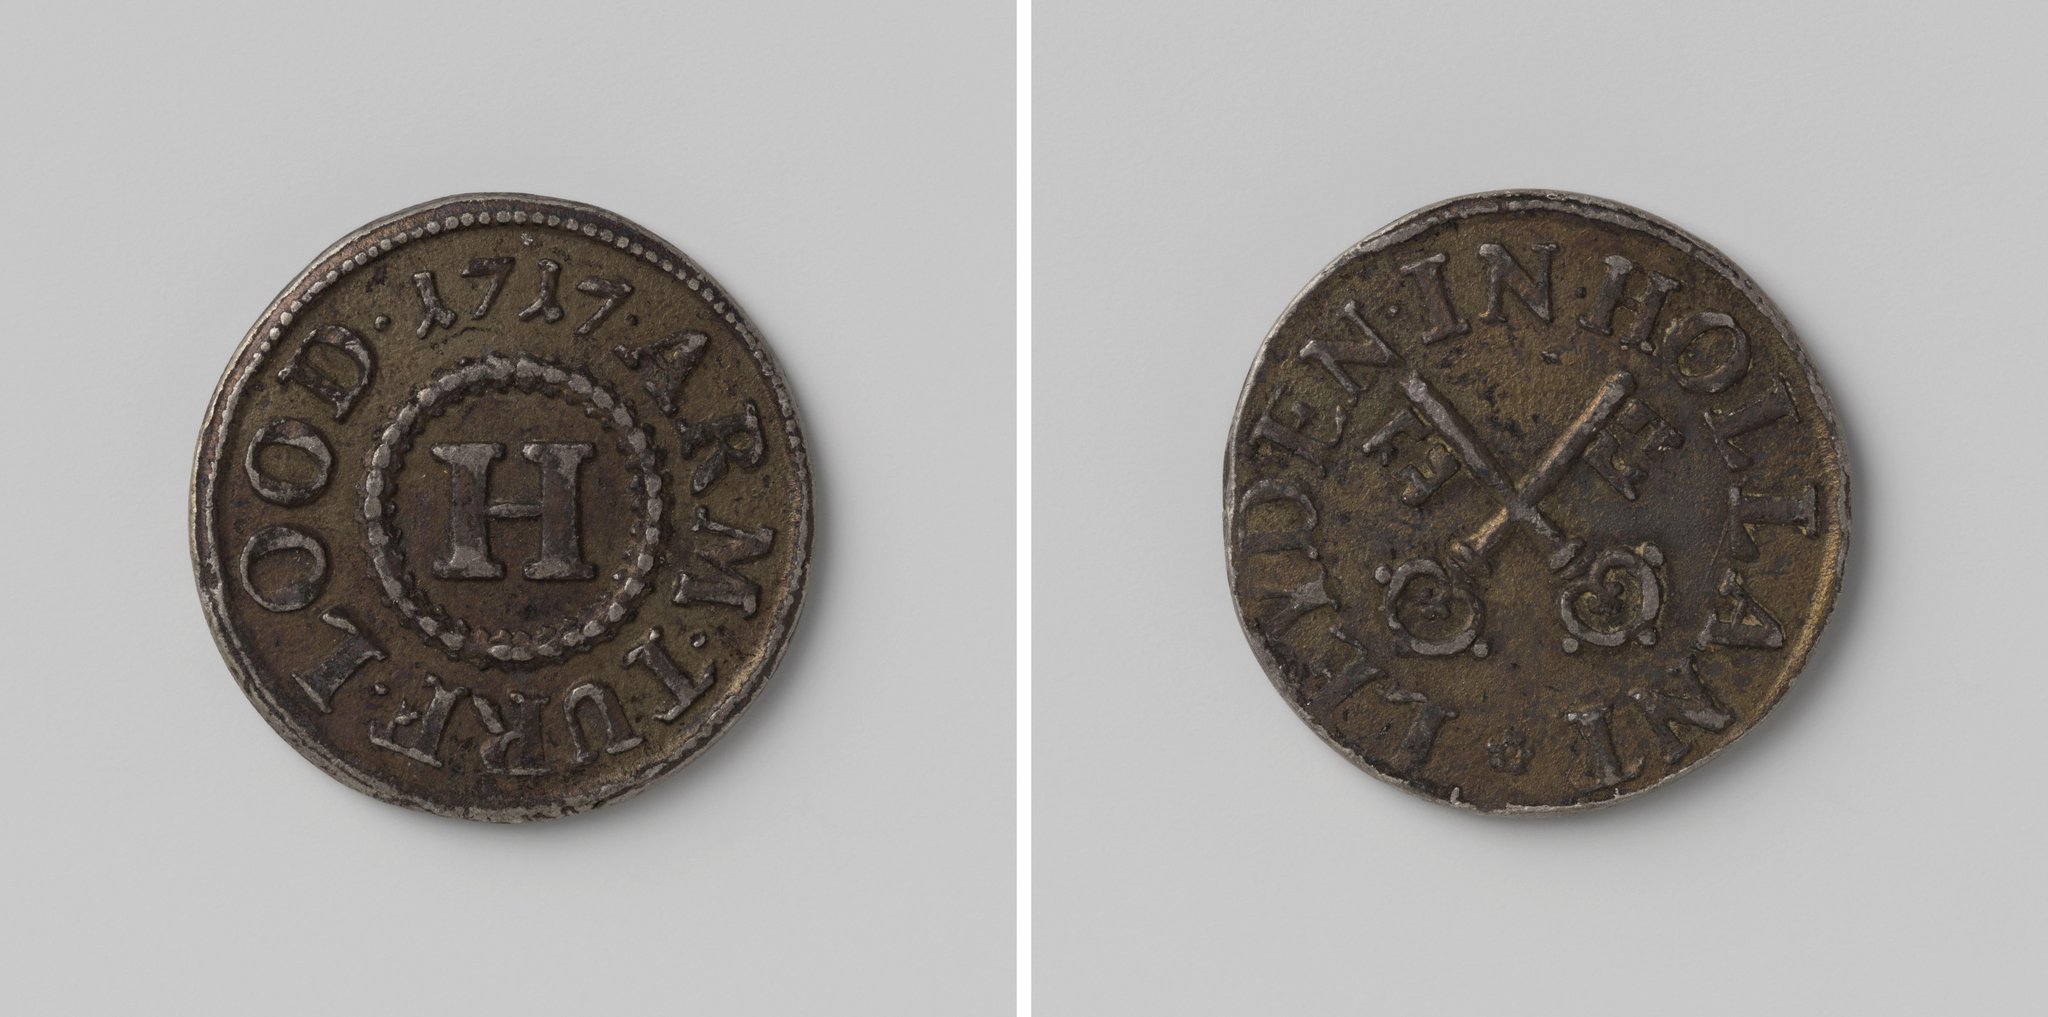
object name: loden penning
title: Stad Leiden, armenpenning die bij uitdeling recht gaf op turf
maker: Anonymous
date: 1717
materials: lead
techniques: striking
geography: leiden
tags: leiden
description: Loden penning. Voorzijde: letter H binnen kabelrand en omschrift. Keerzijde: twee gekruiste sleutels binnen omschrift.